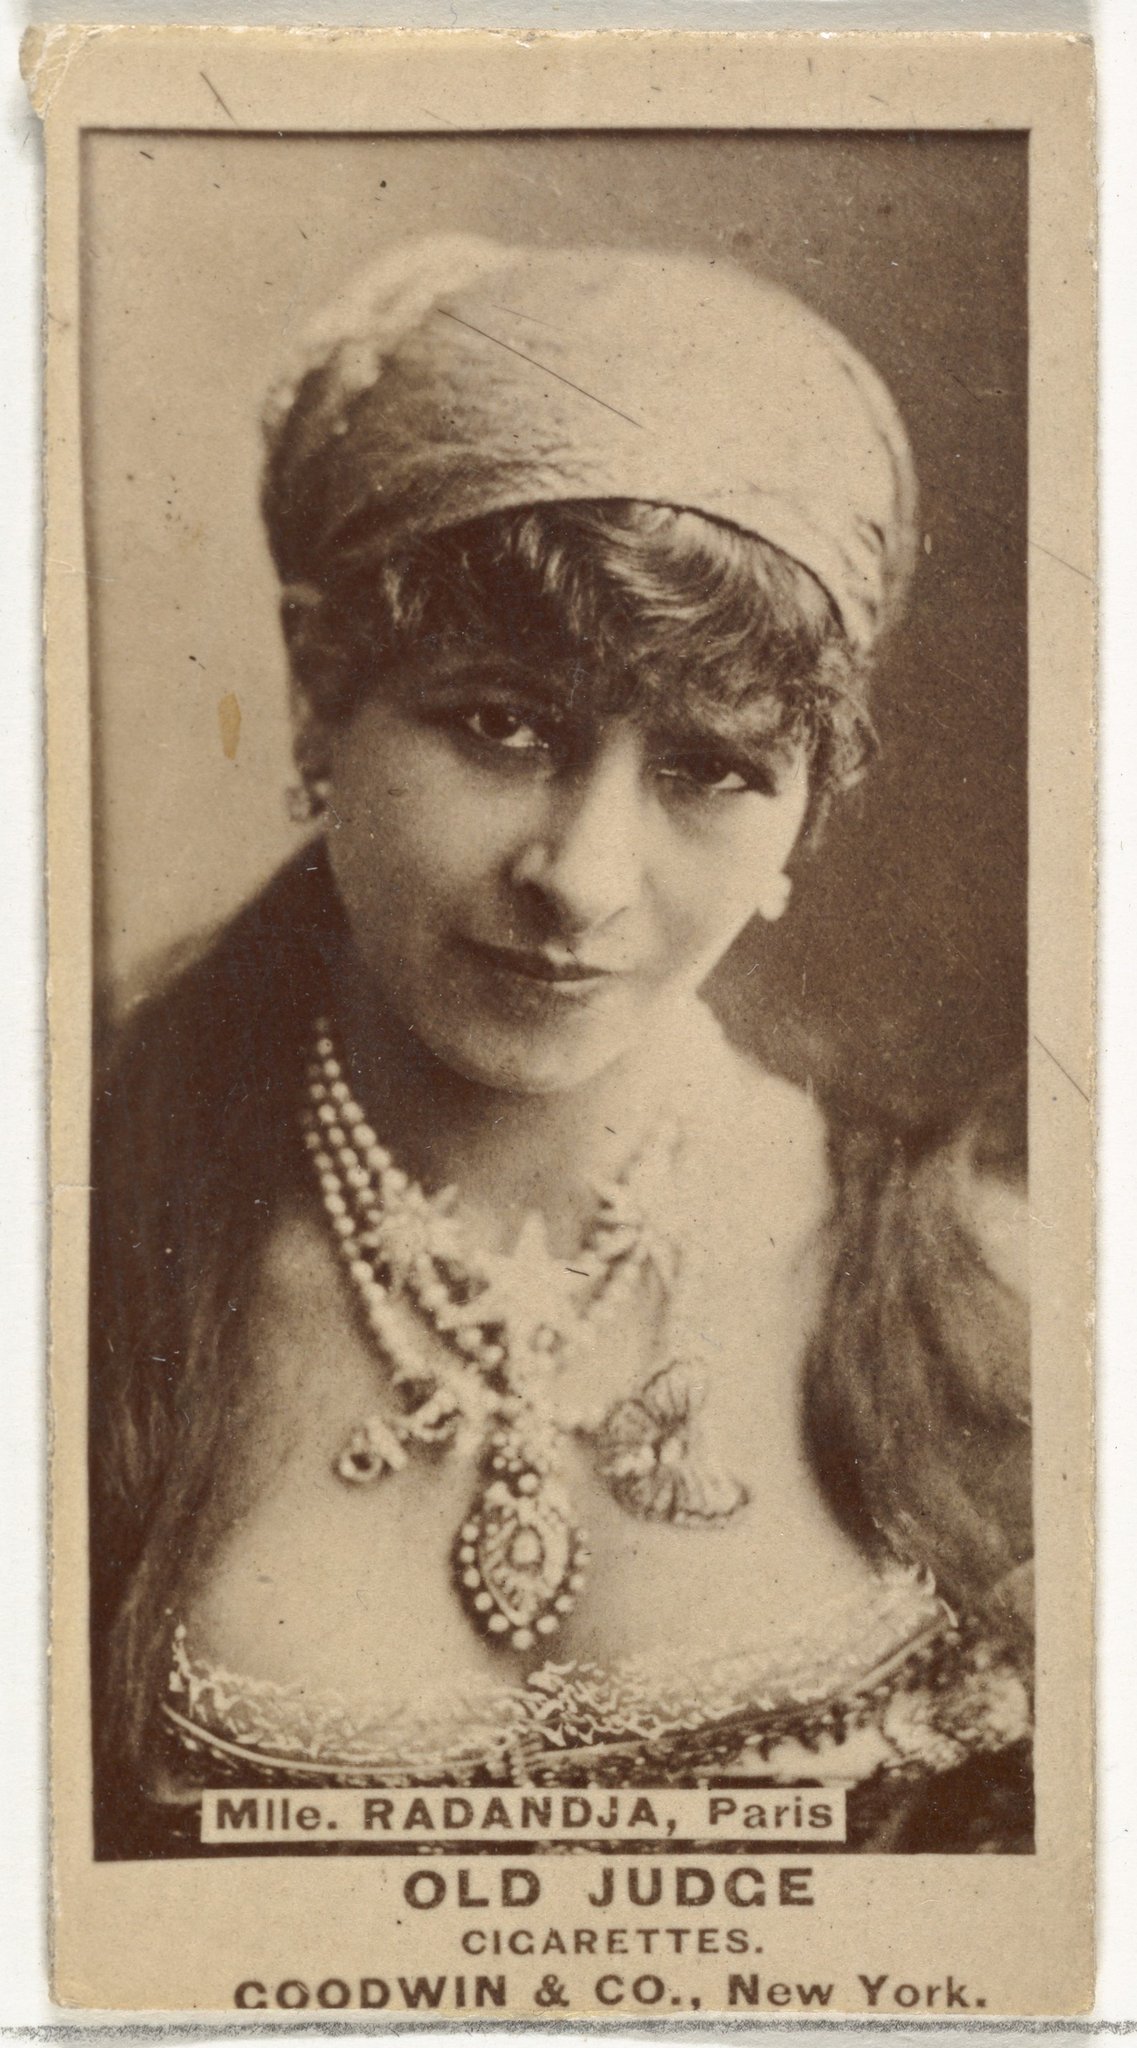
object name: photograph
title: Mlle. Radandja, Paris, from the Actors and Actresses series (N171) for Old Judge Cigarettes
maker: goodwin & company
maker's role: publisher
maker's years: 1850-1950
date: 1886-1890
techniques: albumen silver print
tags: portraits,women,actresses